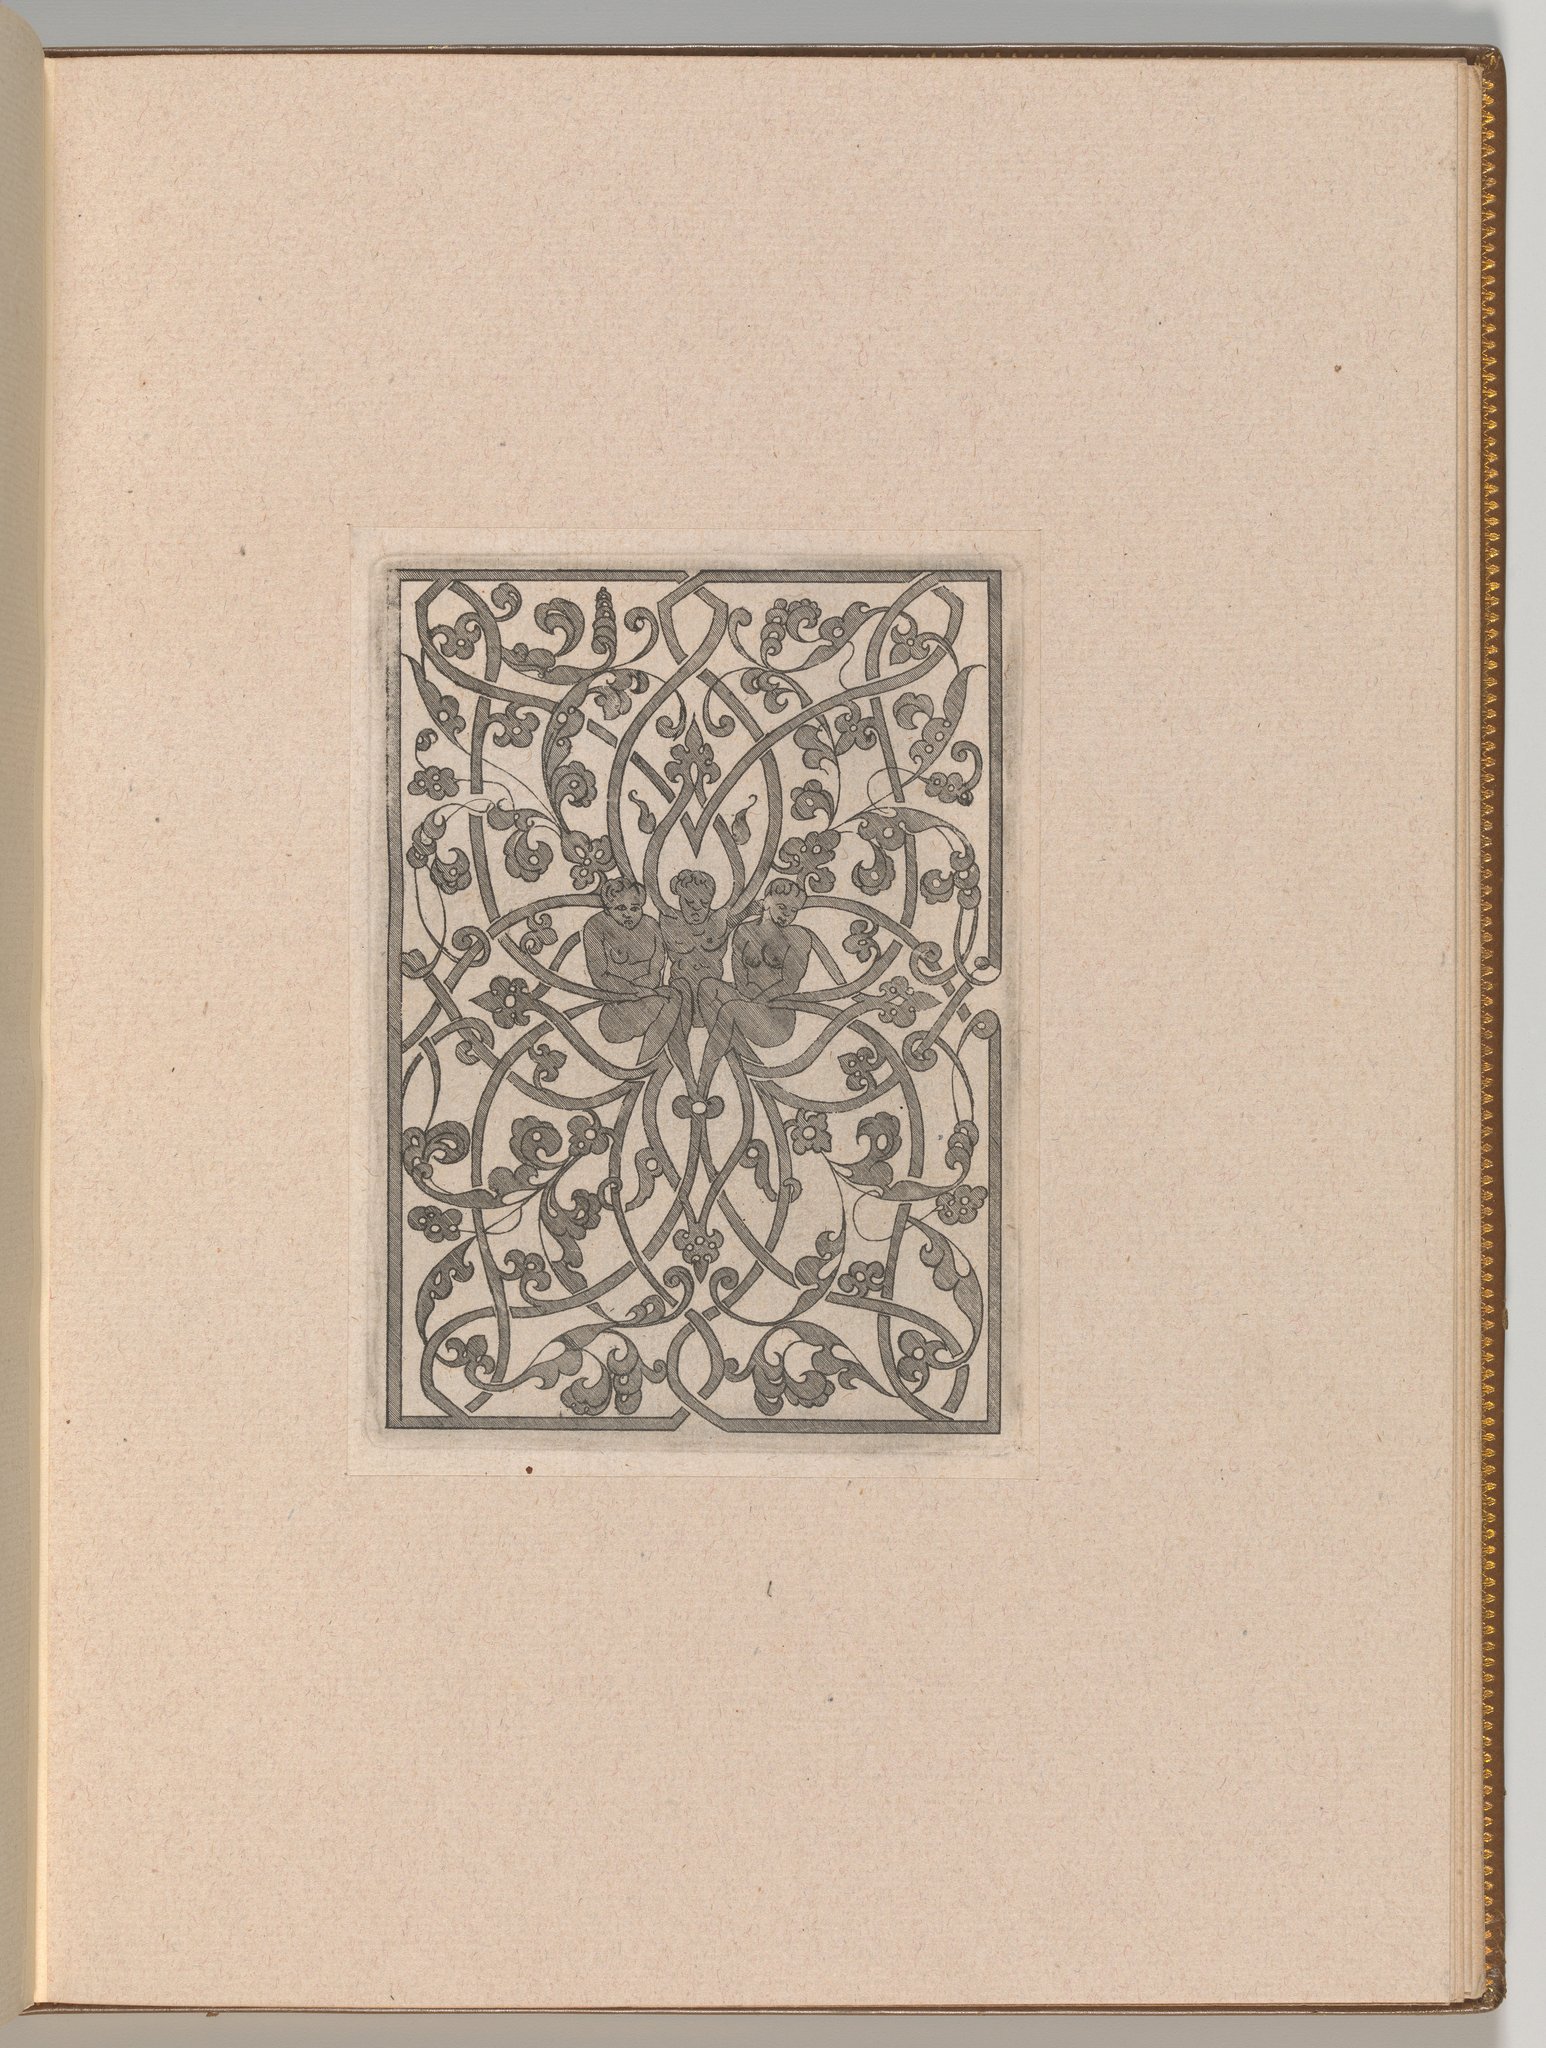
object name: album print ornament architecture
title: Copies after the 'Livre contenant passement de moresques' (plate 8)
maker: jacques androuet du cerceau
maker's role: artist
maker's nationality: french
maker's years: 1510-1585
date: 1801-1900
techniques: etching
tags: female nudes